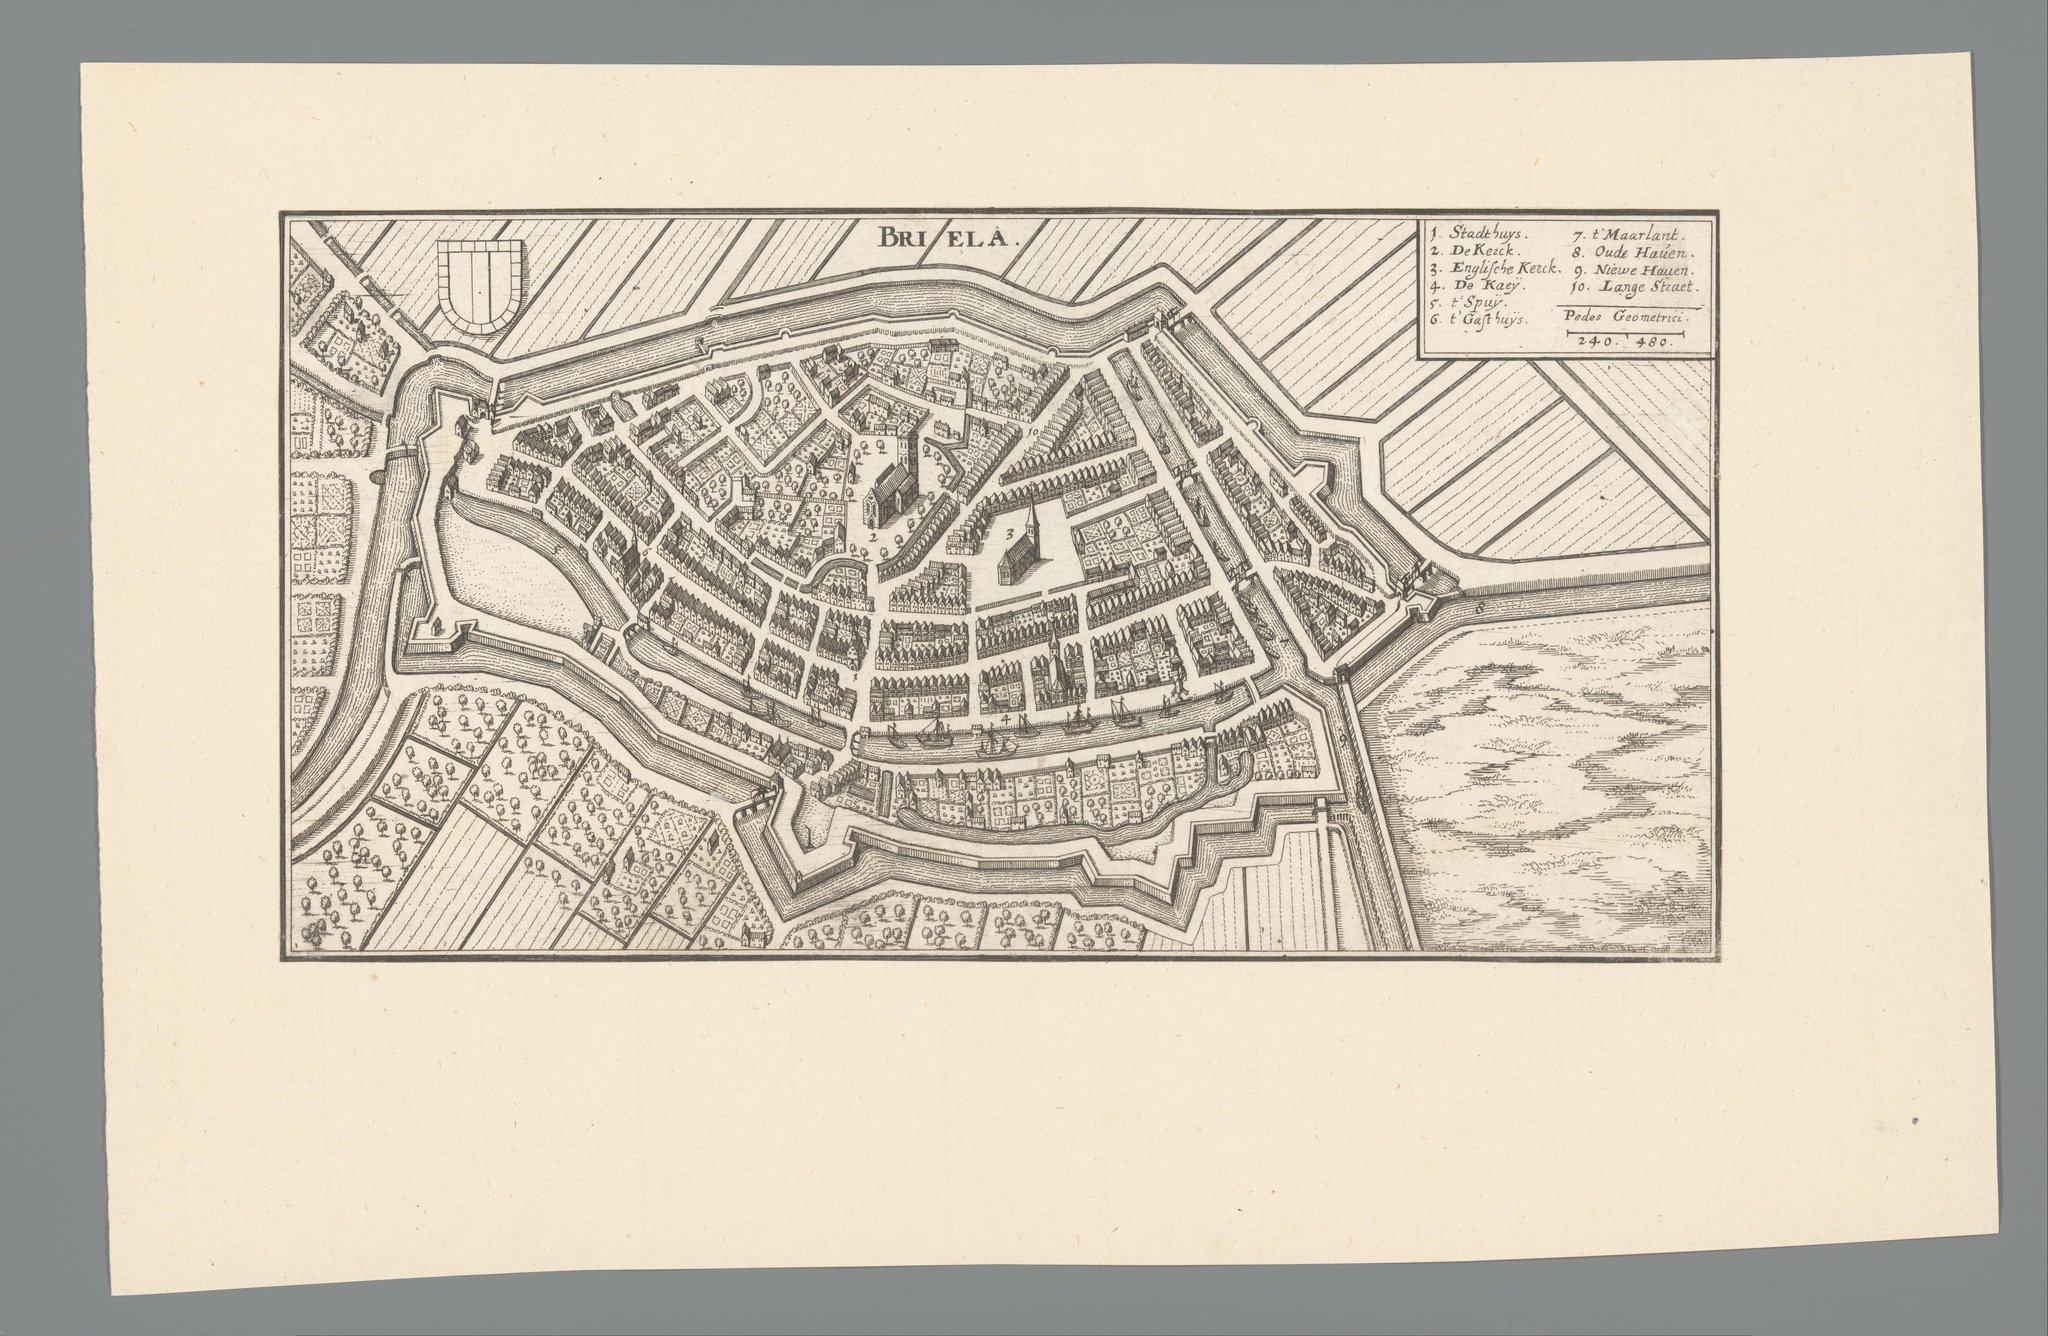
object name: print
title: Plattegrond van Brielle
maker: Anonymous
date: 1670-1730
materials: paper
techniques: etching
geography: netherlands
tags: maps of cities, brielle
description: Linksboven het stadswapen, rechtsboven een legenda met de nummers 1-10.